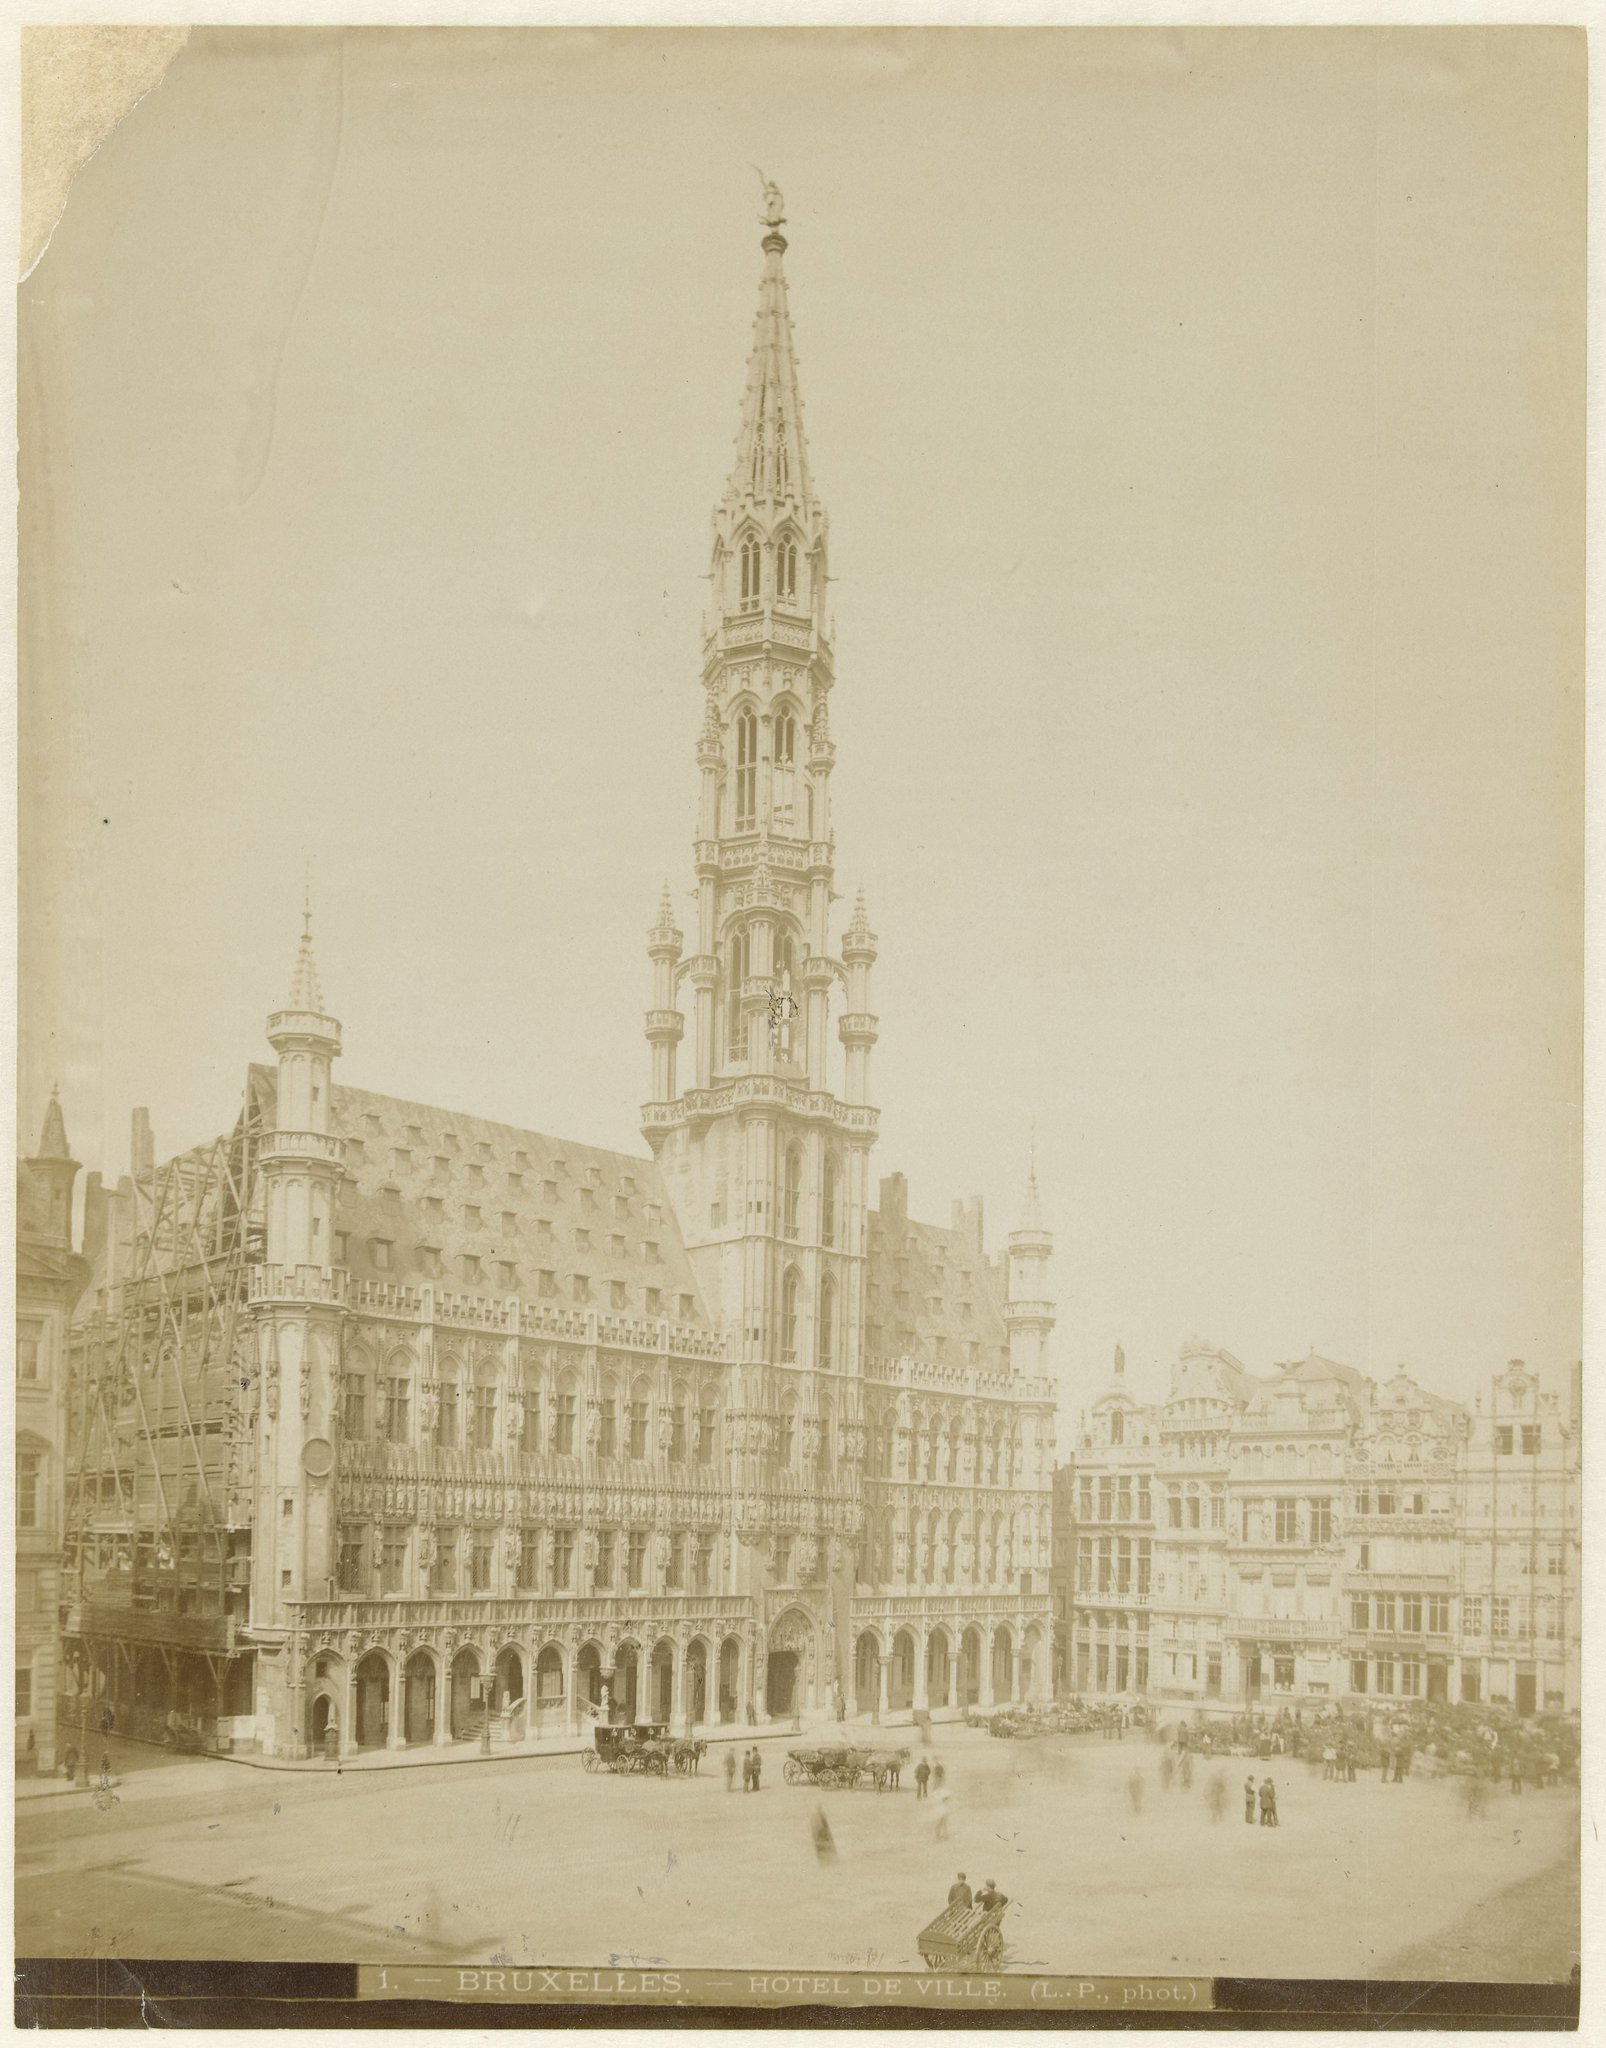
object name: photograph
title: Hotel de Ville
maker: louis antoine pamard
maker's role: fotograaf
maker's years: 1840-1893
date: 1870-1900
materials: paper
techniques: albumen print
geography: brussels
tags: townhall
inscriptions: number: ‘1’